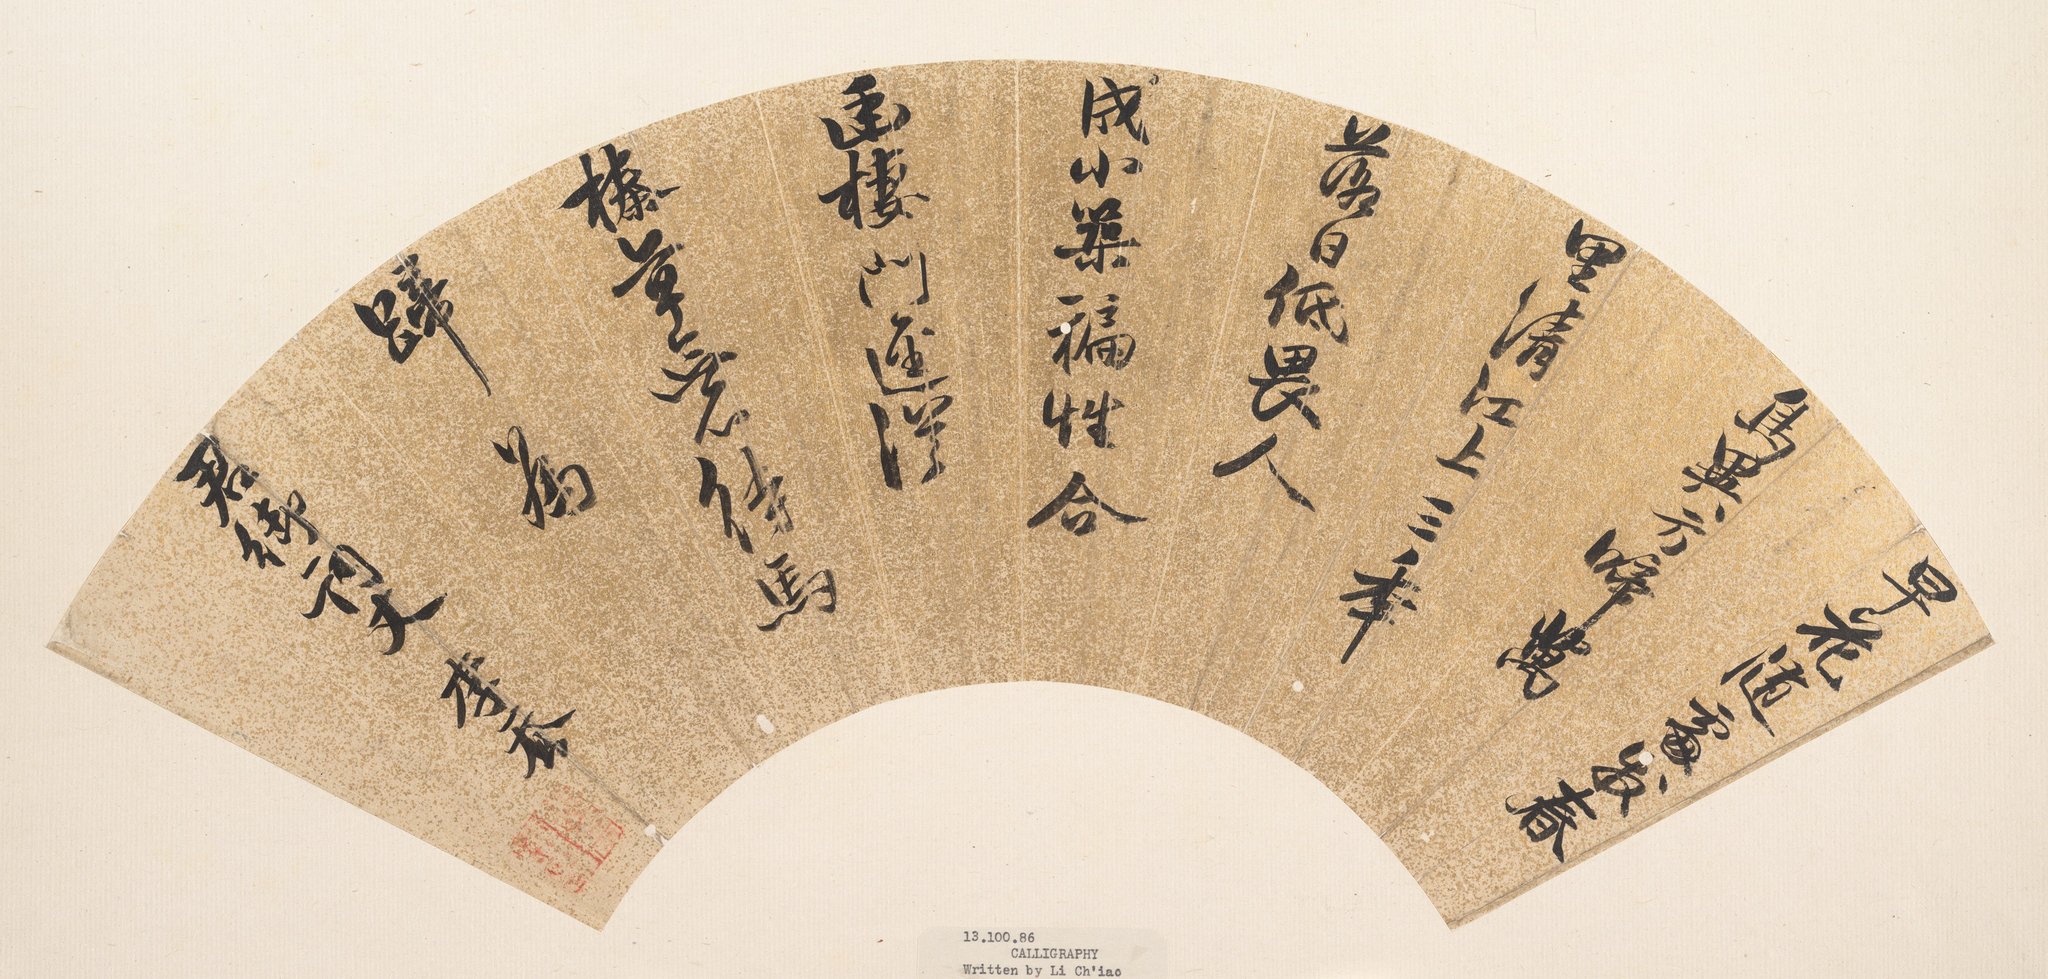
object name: folding fan mounted a an album leaf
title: Calligraphy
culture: chinese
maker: li qiao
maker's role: artist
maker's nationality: chinese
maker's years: 1350-1650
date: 1368-1644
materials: ink, paper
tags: calligraphy